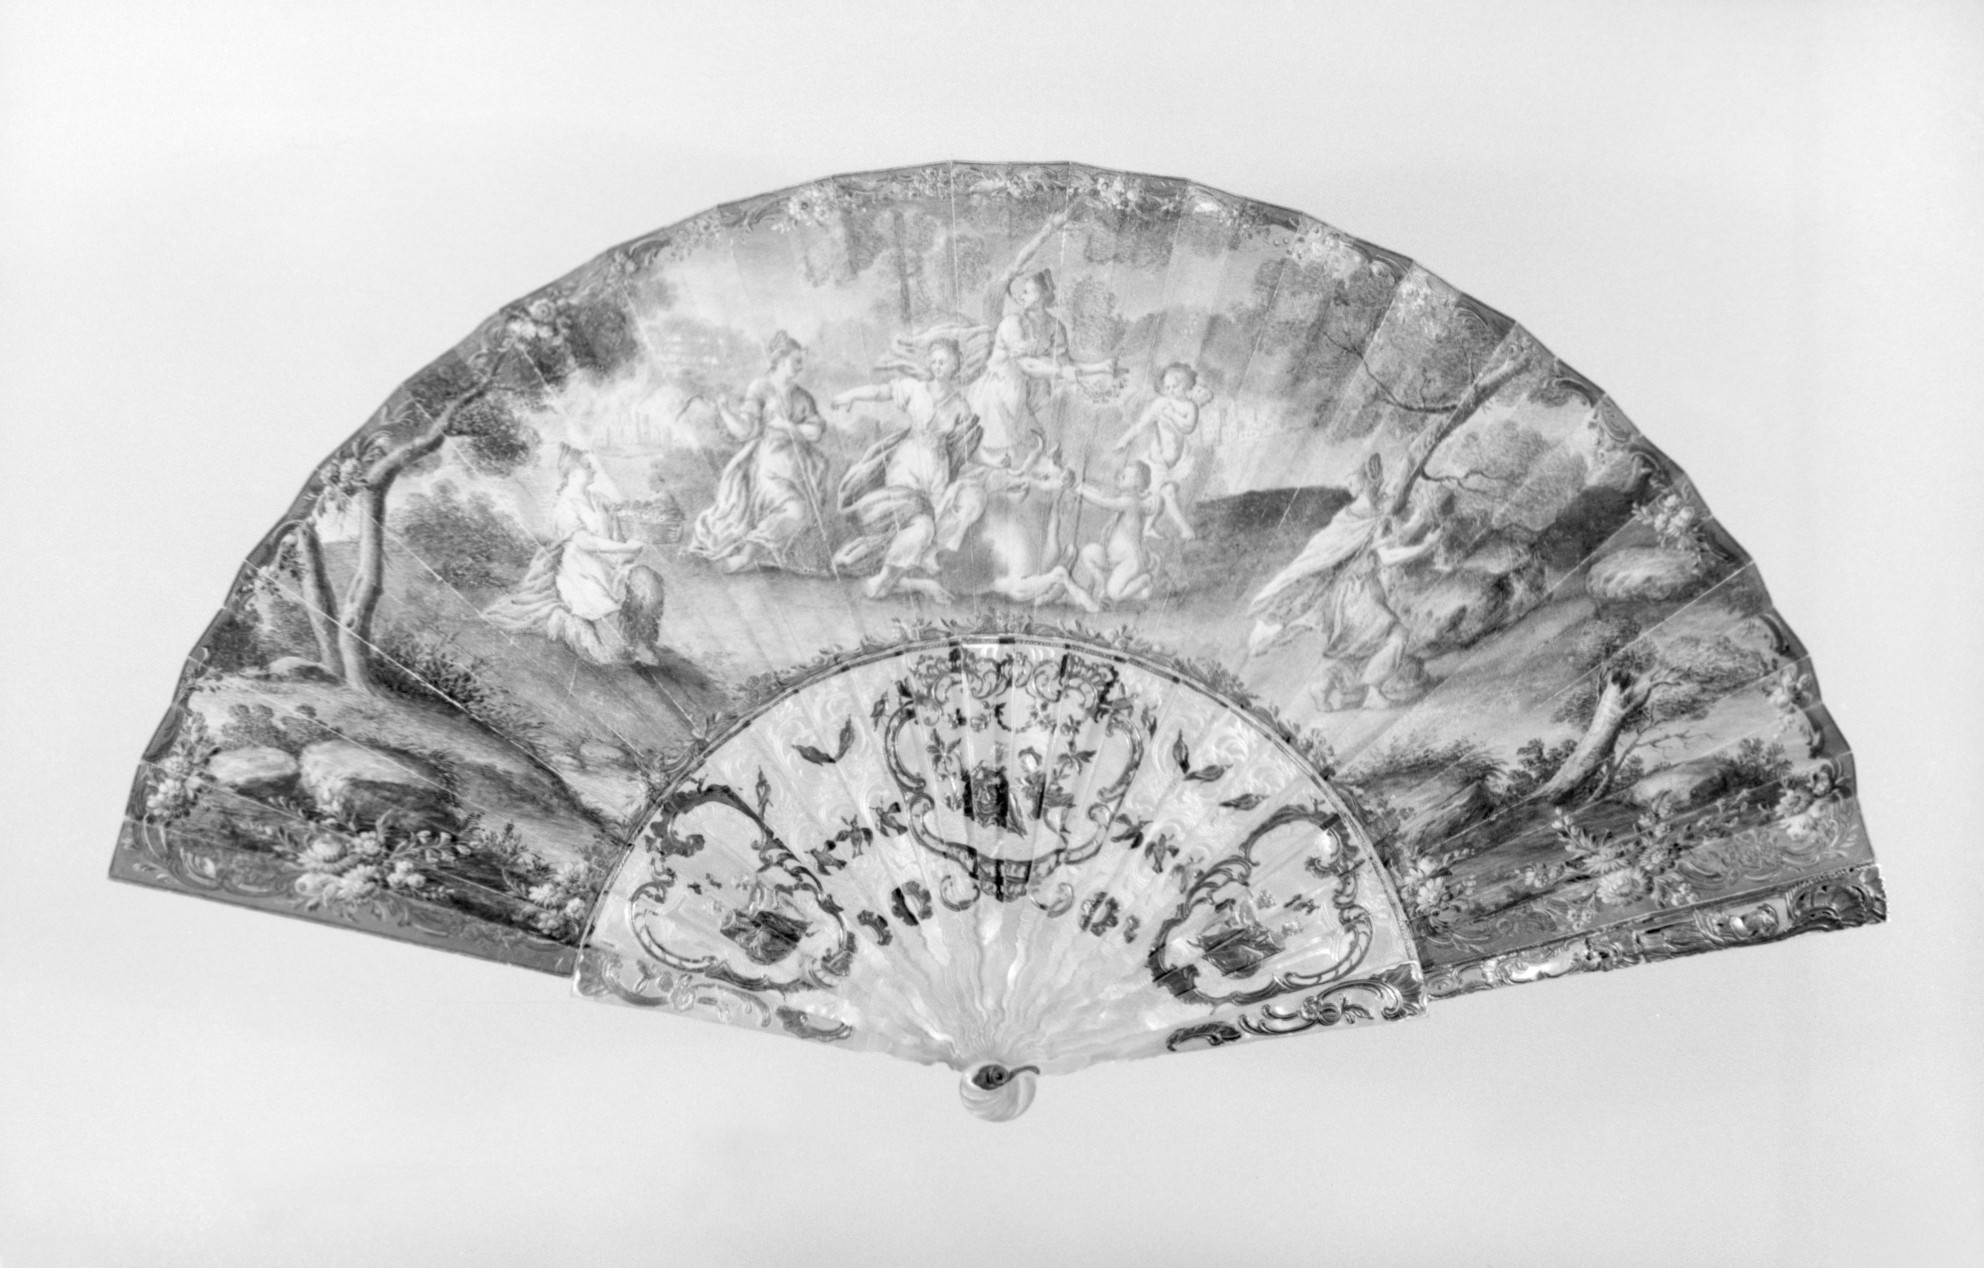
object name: fan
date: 1701-1800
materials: mother of pearl, parchment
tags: women,bulls